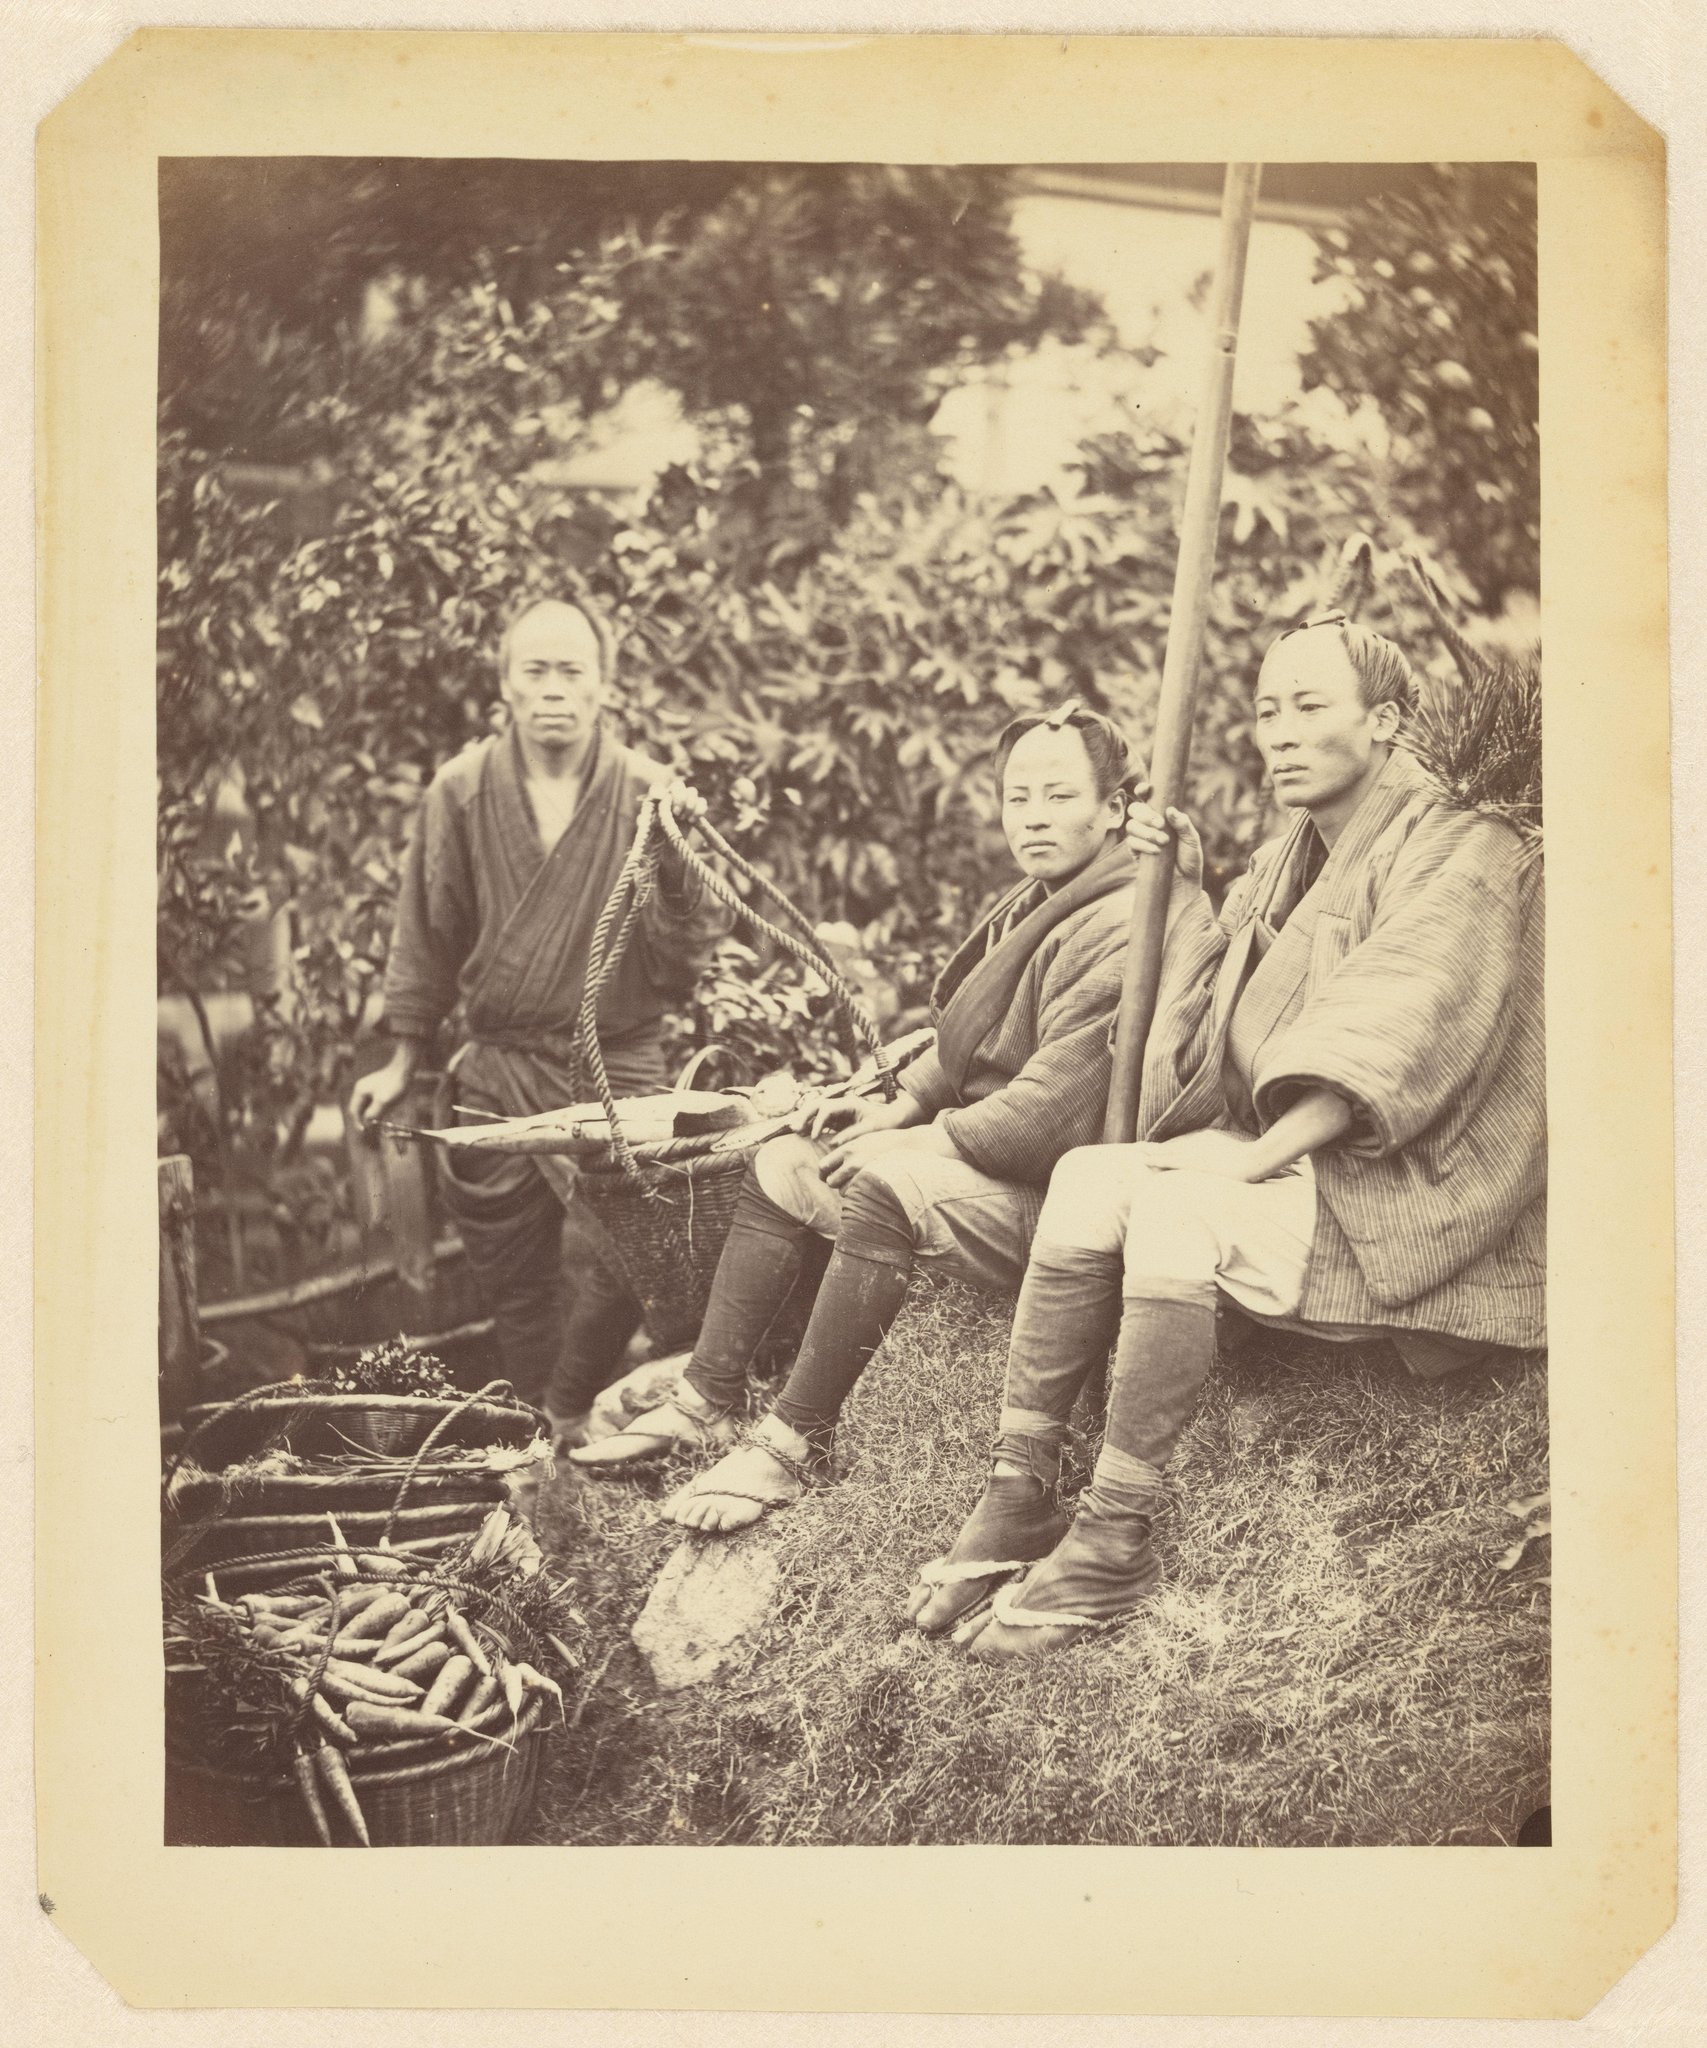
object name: photograph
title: Three farmers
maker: antoon bauduin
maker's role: amateurfotograaf, hoogleraar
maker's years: 1820-1885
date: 1863-1870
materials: paper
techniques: albumen print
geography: japan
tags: japan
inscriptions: number: ‘BD107’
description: In contrast to the pictures of samurai, this one is less concerned with western stereotypes of the exotic and picturesque. These three men were probably farmers, though we know neither their names nor anything else about them. Within Bauduin’s oeuvre, it is a remarkably ‘ordinary’ scene of ‘ordinary’ people.